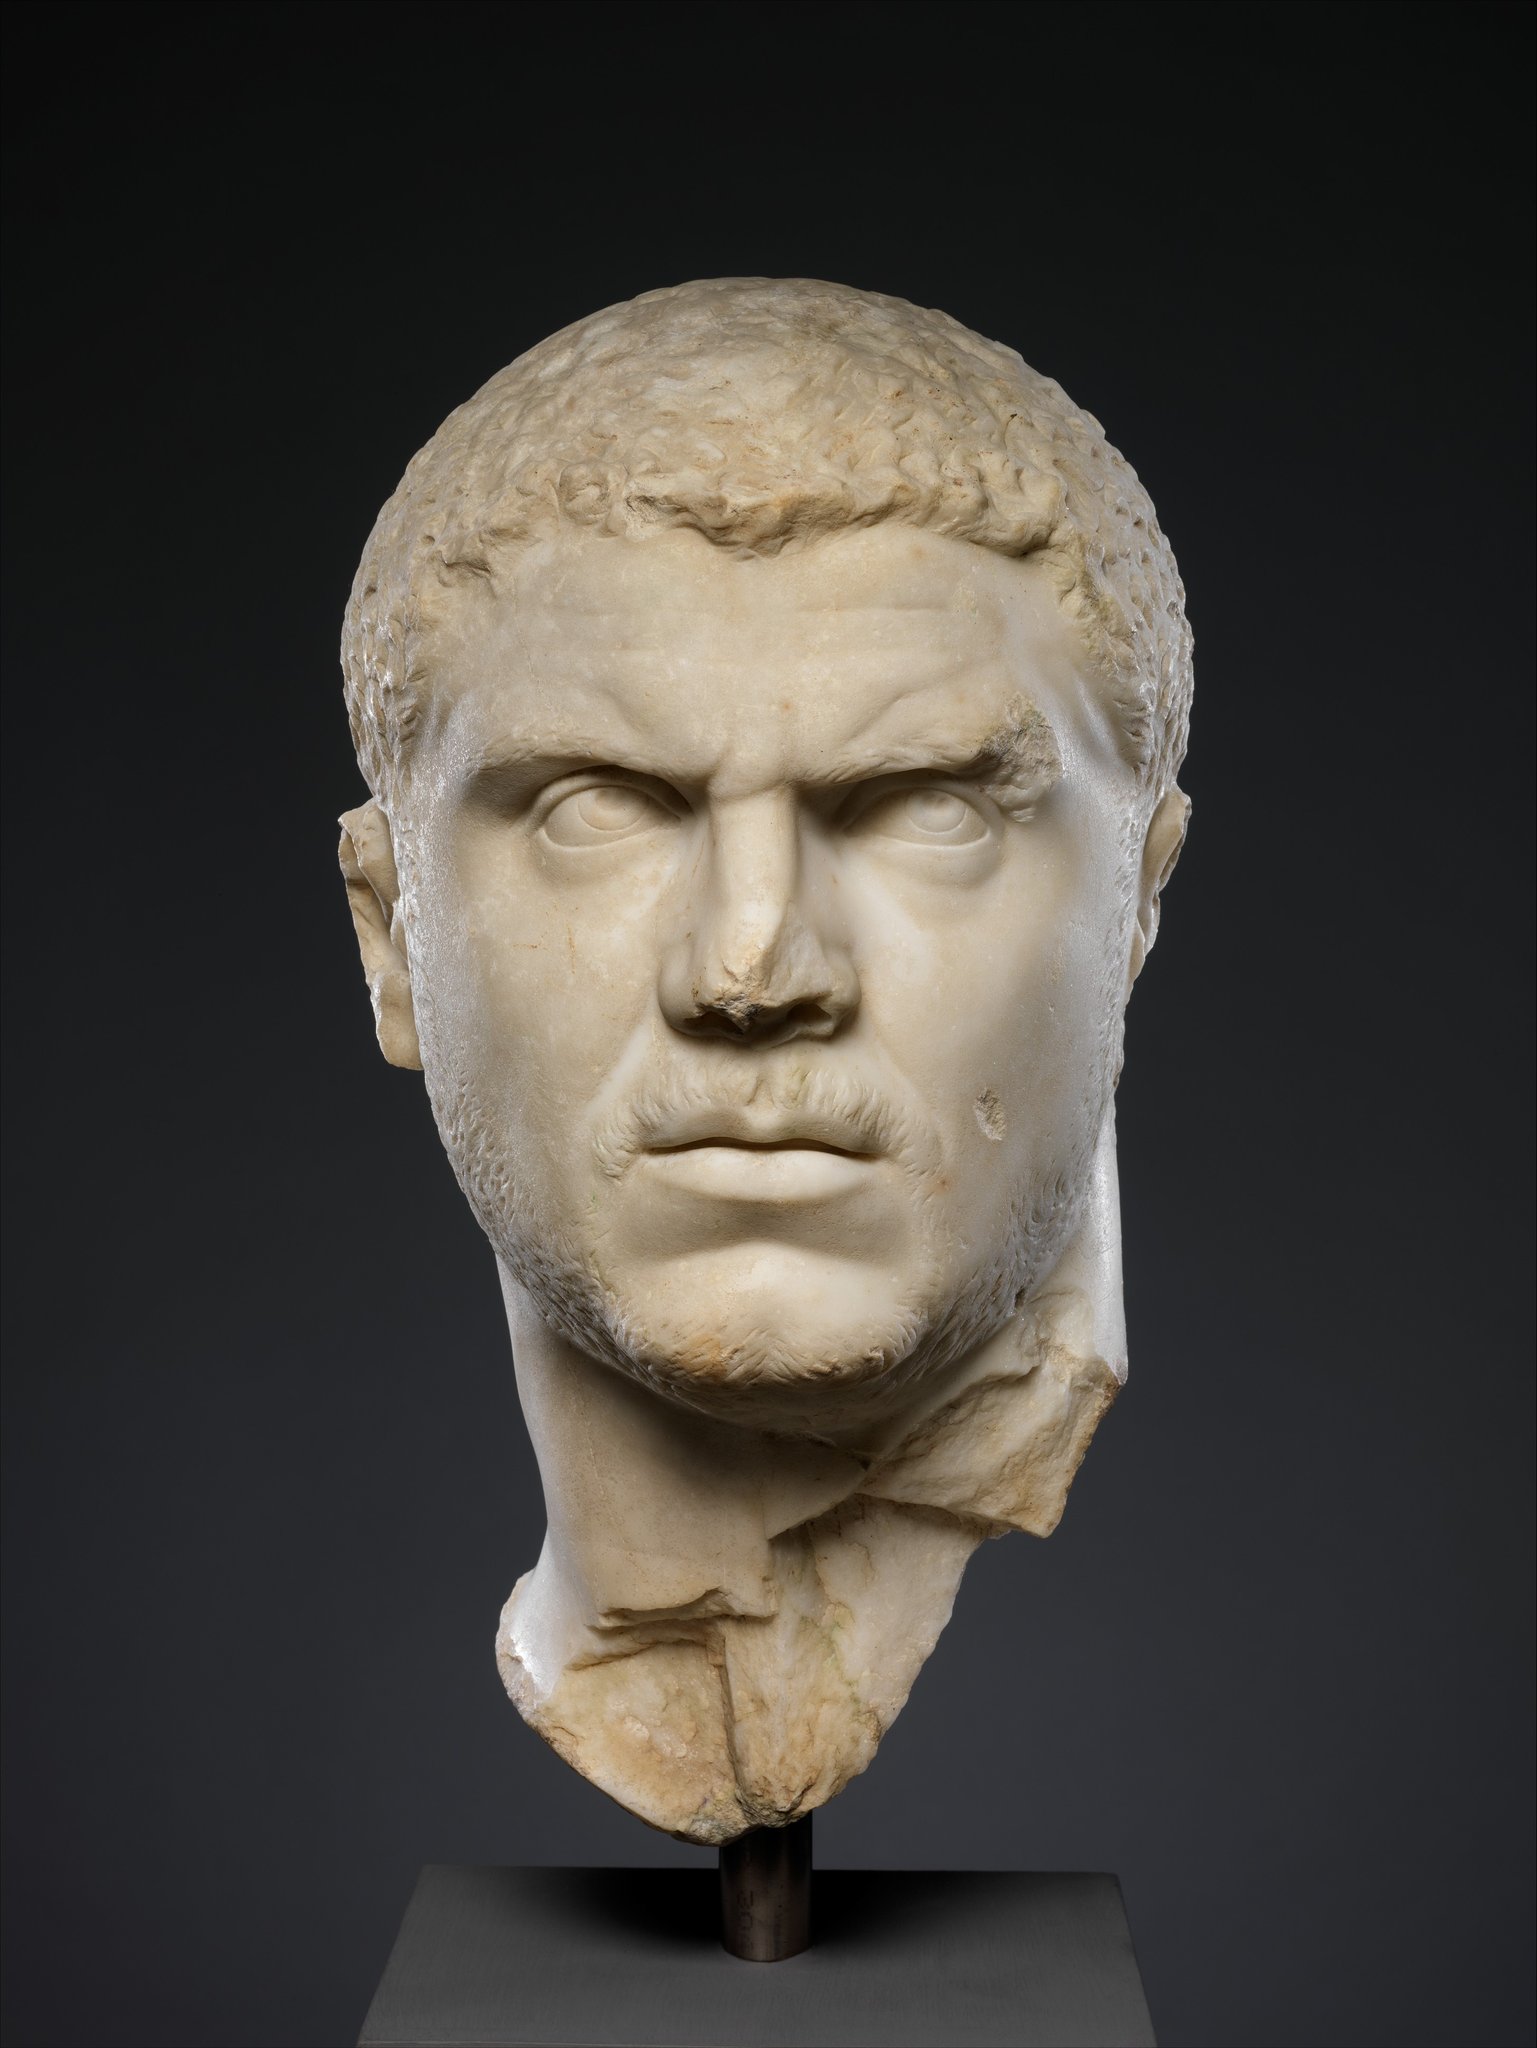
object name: portrait head of the emperor marcus aurelius antoninus called caracalla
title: Marble portrait of the emperor Caracalla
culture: roman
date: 212-217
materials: marble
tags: men,portraits